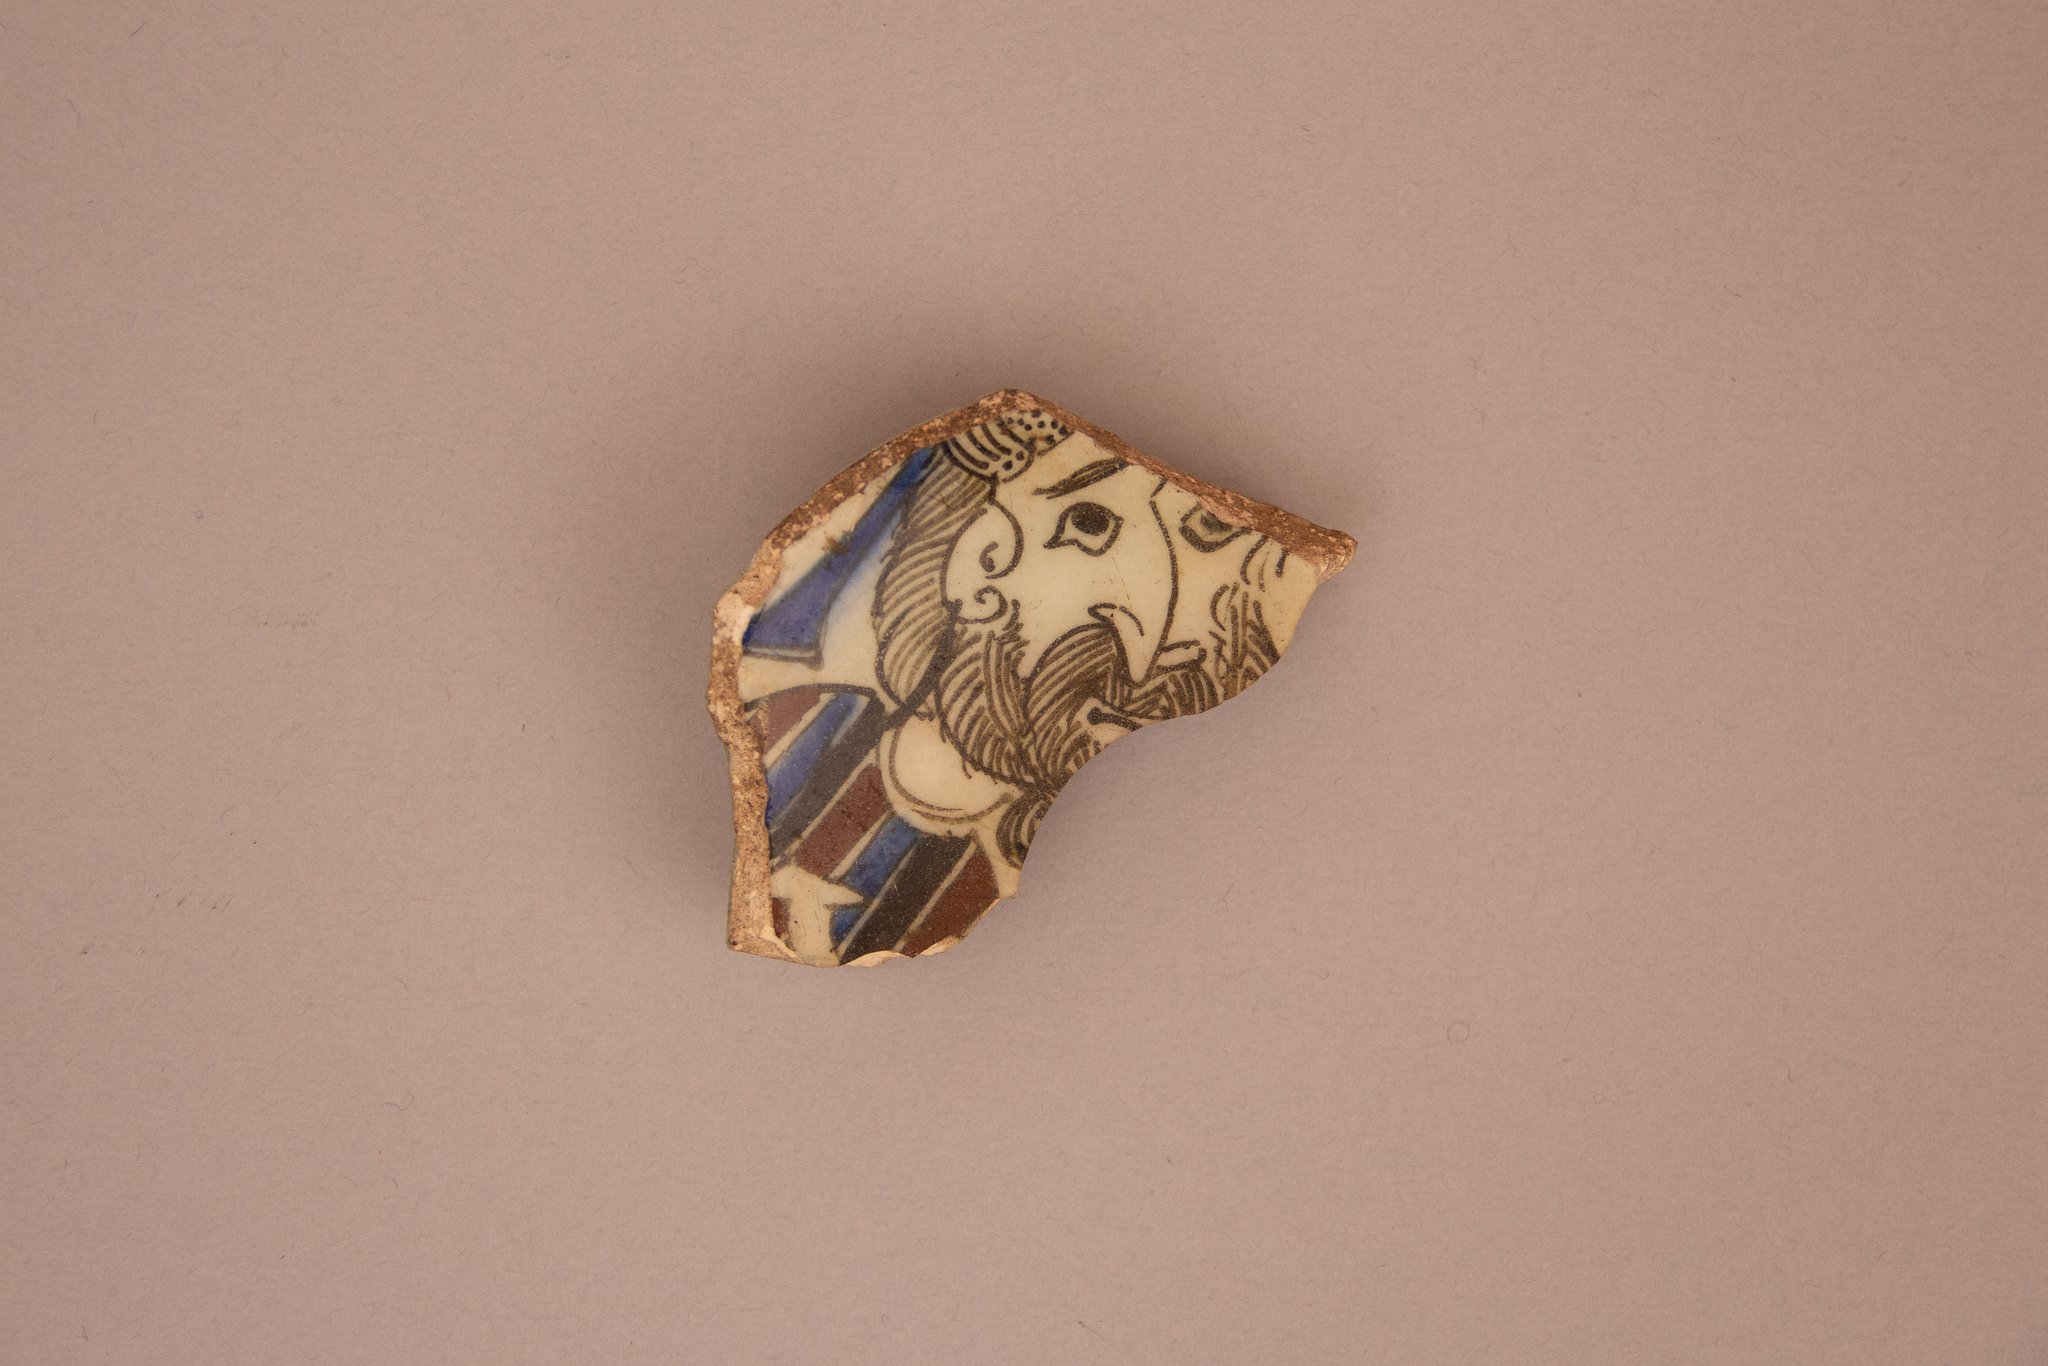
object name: fragment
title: Fragment of an Open Vessel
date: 1201-1300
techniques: painting, underglaze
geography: syria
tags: men